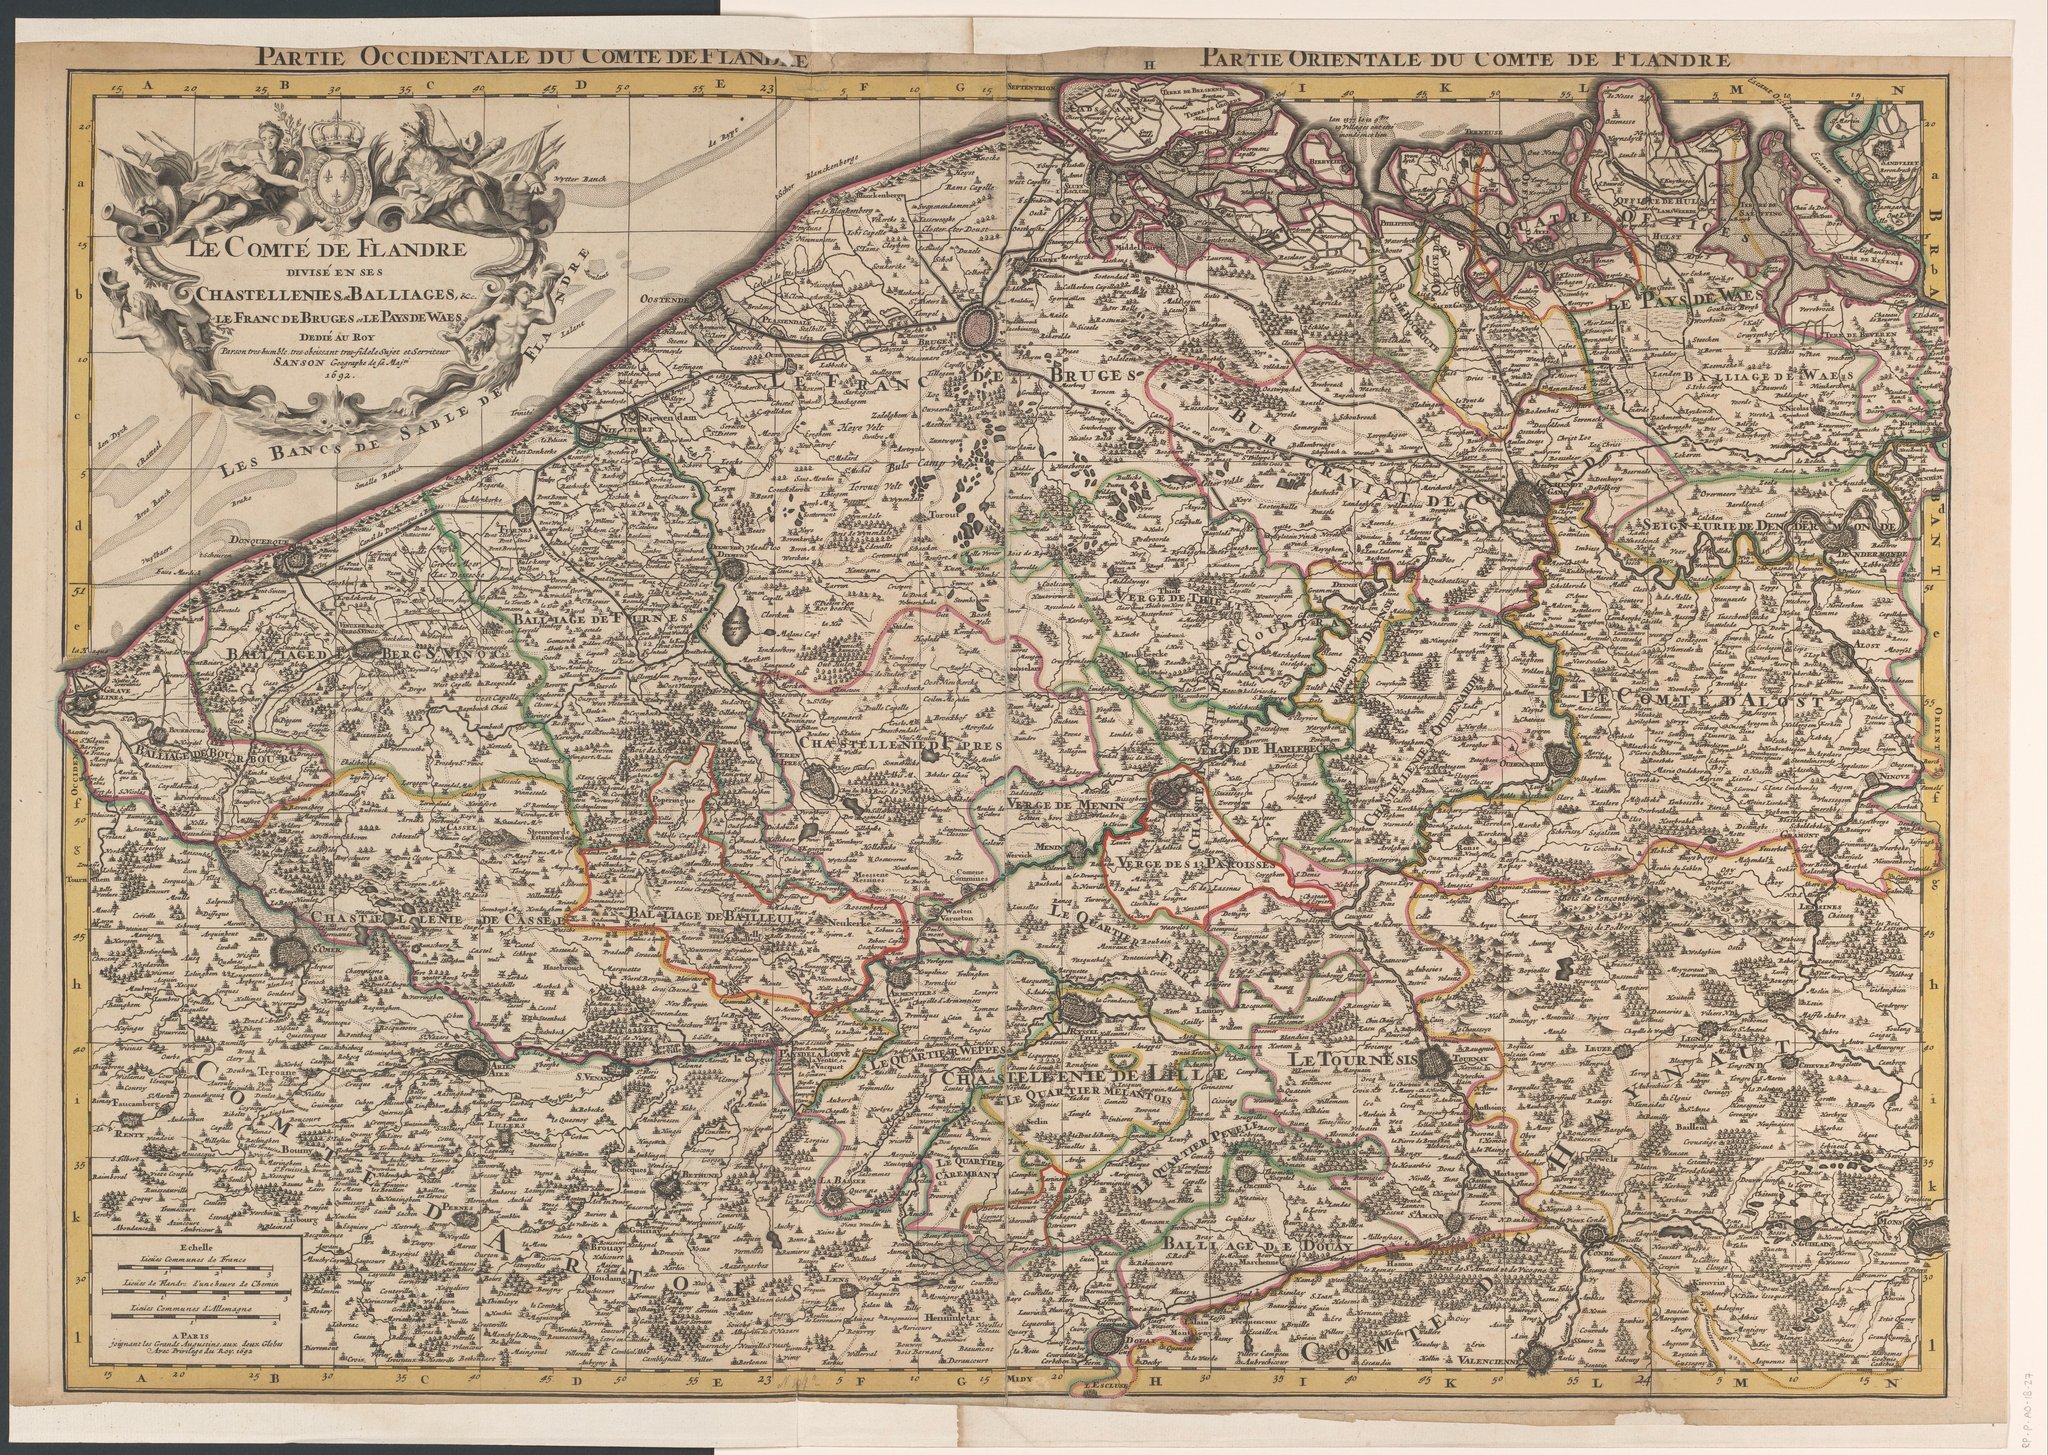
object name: map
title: Kaart van het graafschap Vlaanderen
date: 1692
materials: paper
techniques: engraving, etching, hand coloring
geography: paris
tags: maps of separate countries or regions, armorial bearing, heraldry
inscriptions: collector's mark: Lugt 195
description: Kaart van het graafschap Vlaanderen. Linksboven de titelcartouche met bovenin het wapen van de koning van Frankrijk. Linksonder een cartouche met drie schaalstokken: 3 Lieües Communes de France / 3 Lieües de Flandre d'une heure de Chemin / 2 Lieües Communes d'Allemagne. De kaart is voorzien van een zoekrooster en een gradenverdeling langs de randen.